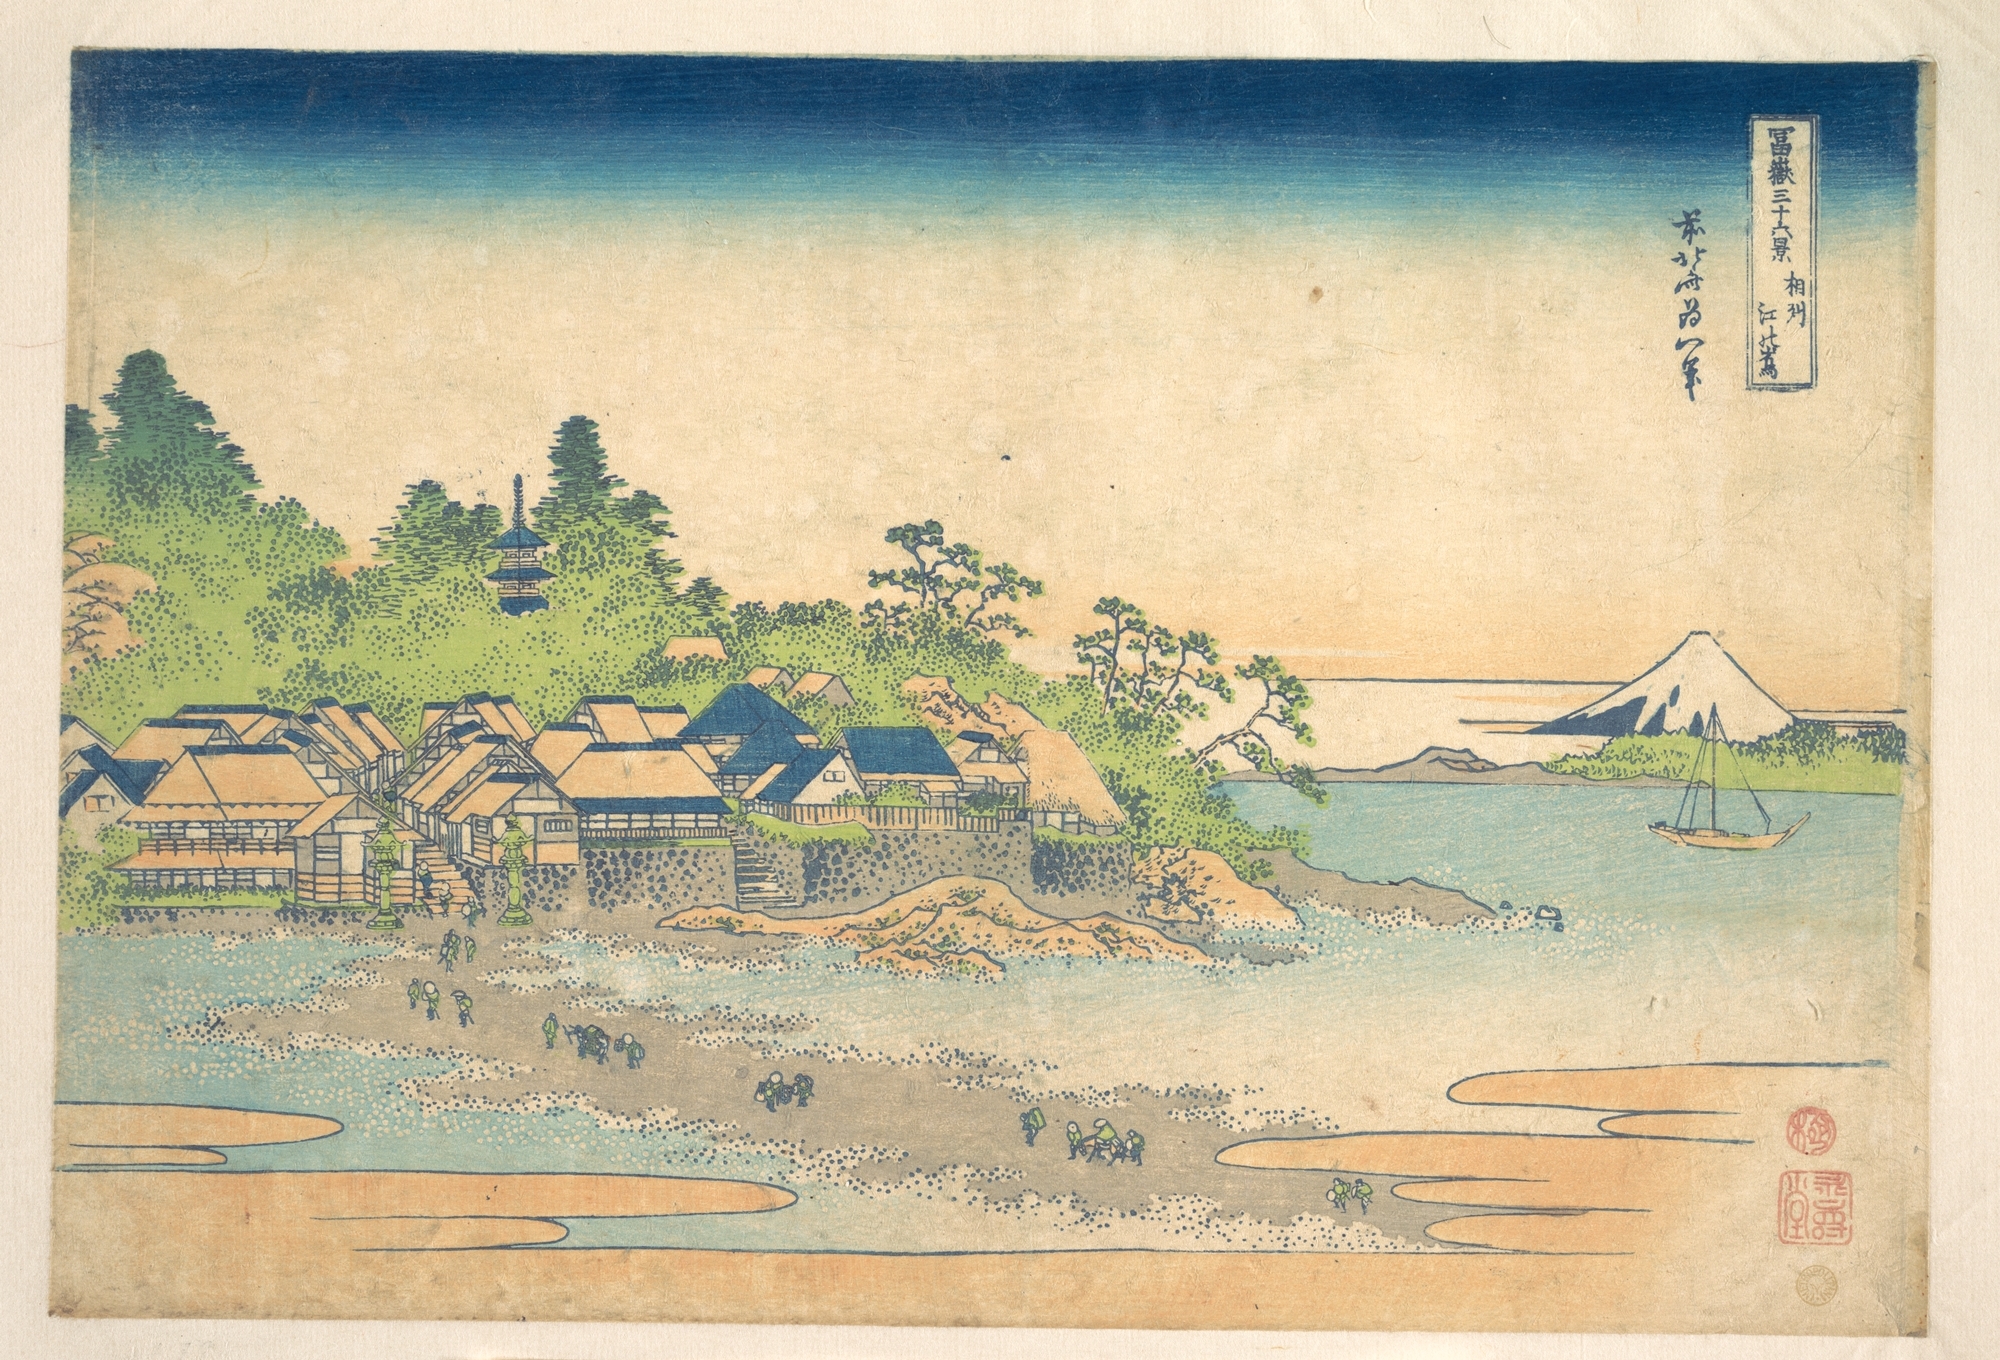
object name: woodblock print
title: Enoshima in Sagami Province (Sōshū Enoshima), from the series Thirty-six Views of Mount Fuji (Fugaku sanjūrokkei)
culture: japanese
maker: katsushika hokusai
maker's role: artist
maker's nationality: japanese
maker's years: 1760-1849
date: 1830-1832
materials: ink, paper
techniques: woodblock print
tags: houses,mountains,landscapes,boats